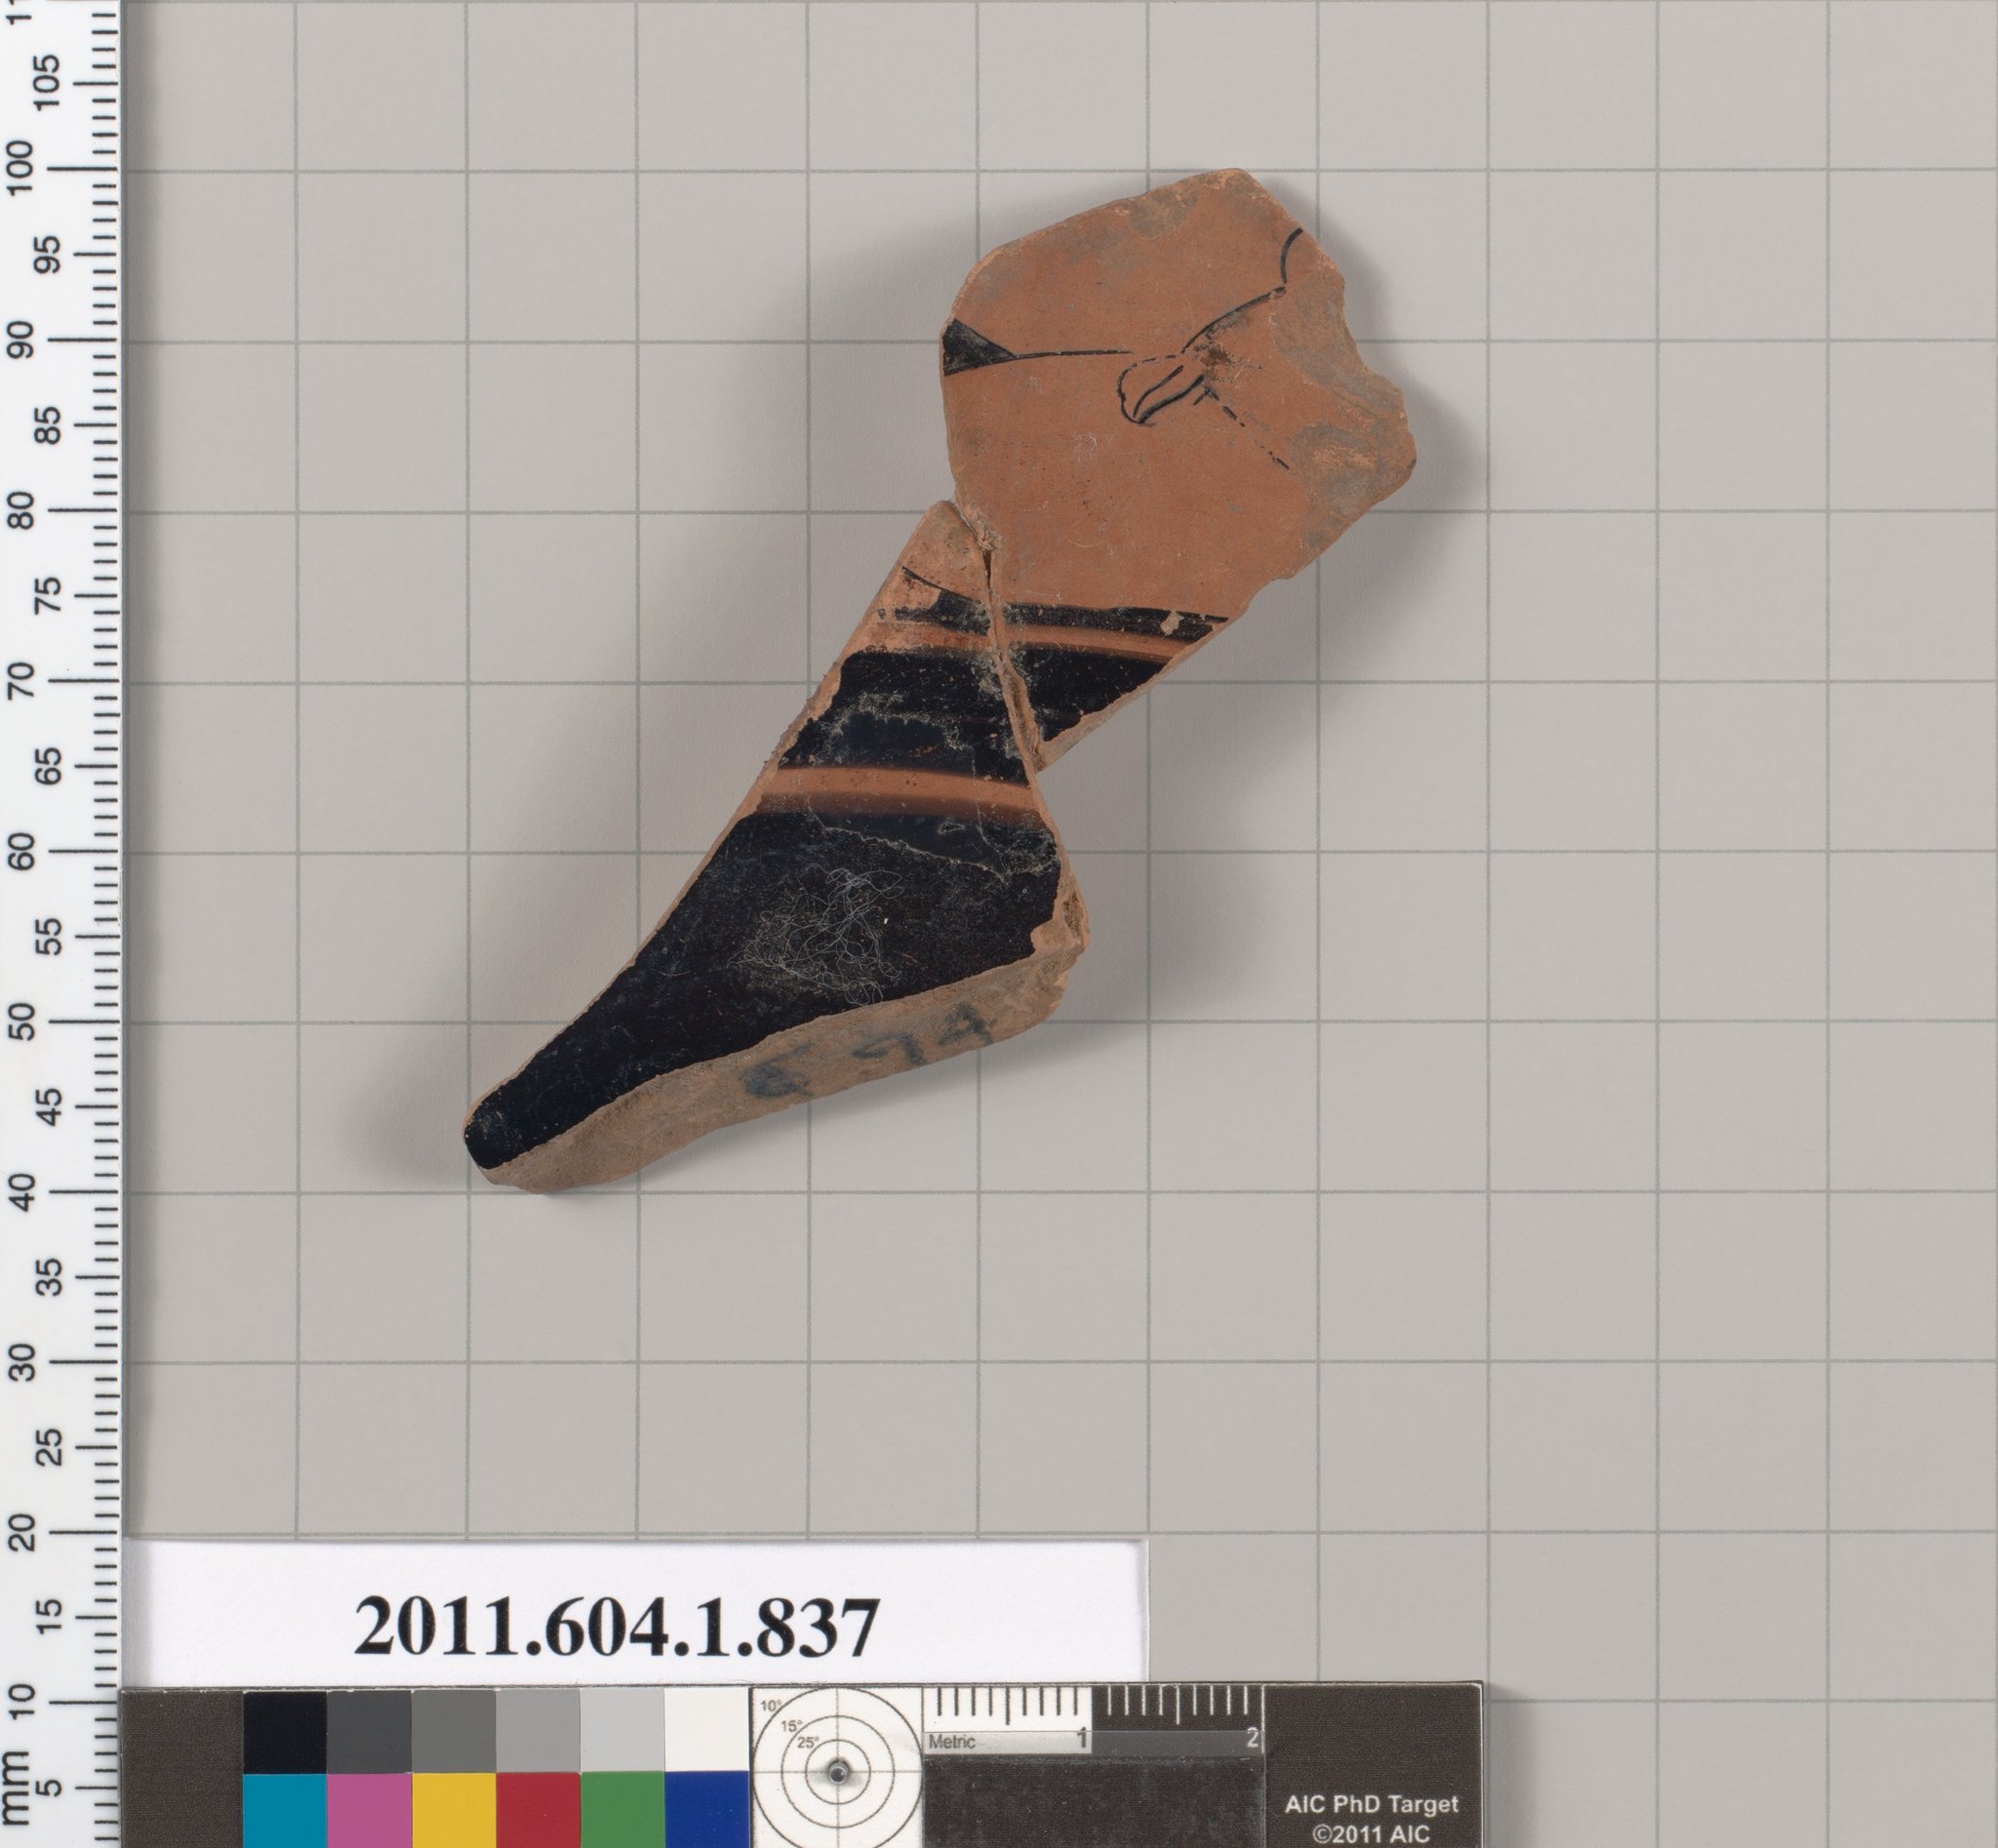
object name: kylix fragment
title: Terracotta fragment of a kylix (drinking cup)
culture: greek, attic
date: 475-451 BCE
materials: terracotta